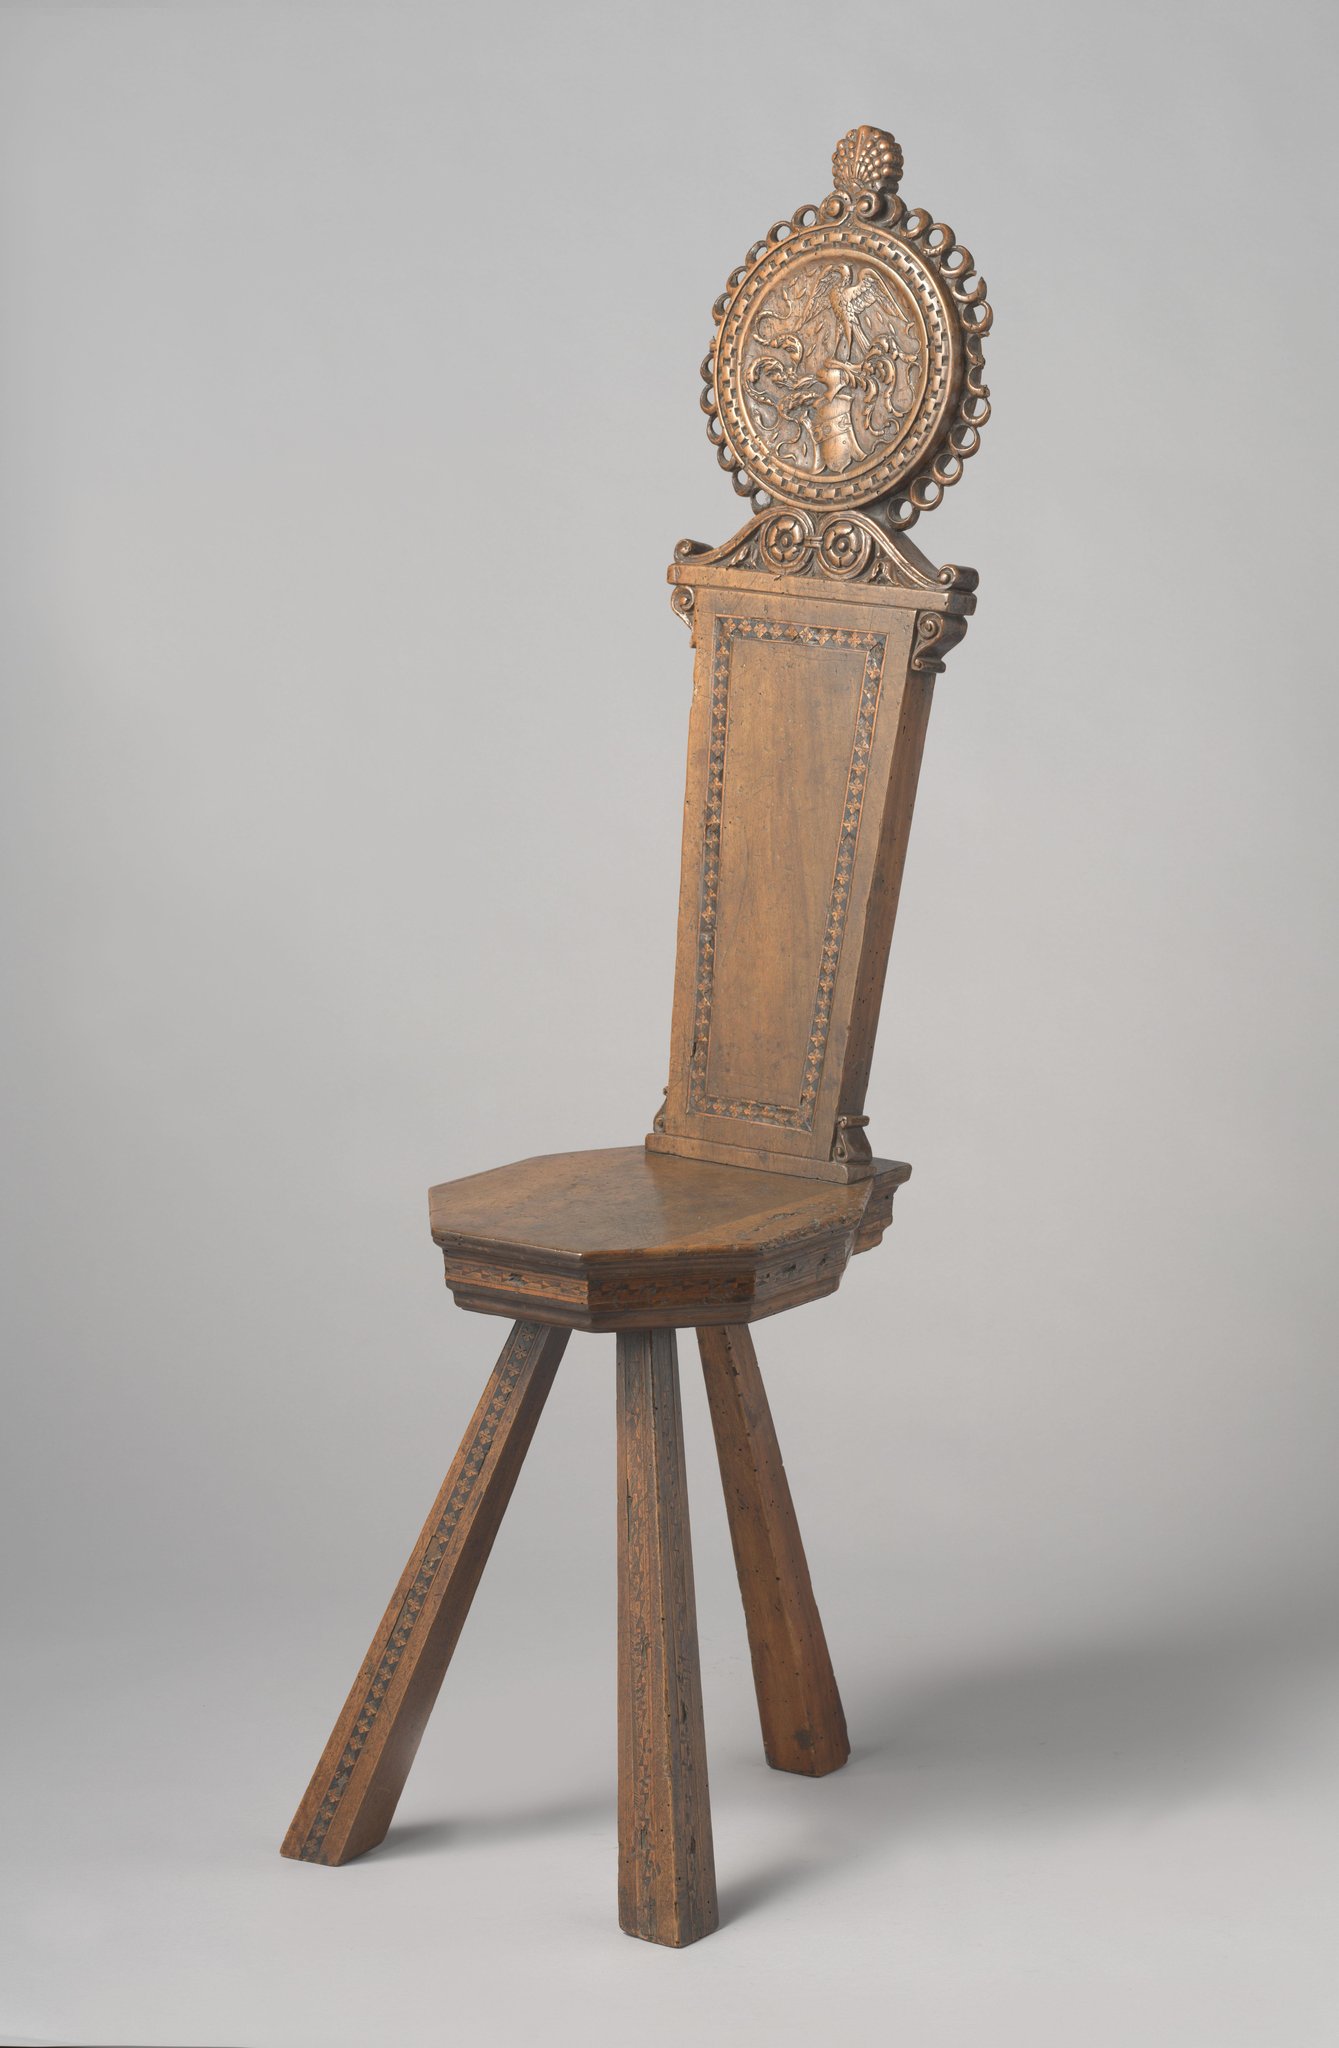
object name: sgabello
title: Sgabello van notenhout versierd met intarsia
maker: Anonymous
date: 1490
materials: wood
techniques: intarsia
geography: florence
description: Notenhouten sgabello versierd met intarsia, rustend op drie in gespreide stand geplaatste, in doorsnede vierkante naar onder zich verbredende poten. De poten, de achthoekige zitting en het gestrekt trapeziumvormige rugraam dragen randen met intarsia. De onder- en bovenkant van de rugstijlen tonen een voluut; op de bovendorpel liggen twee acanthusvoluten die een medaillon dragen, omgeven door een rand van halve manen en bekroond met een palmet, dat aan twee kanten het wapen der Strozzi toont. Zie: BK-16878-b.